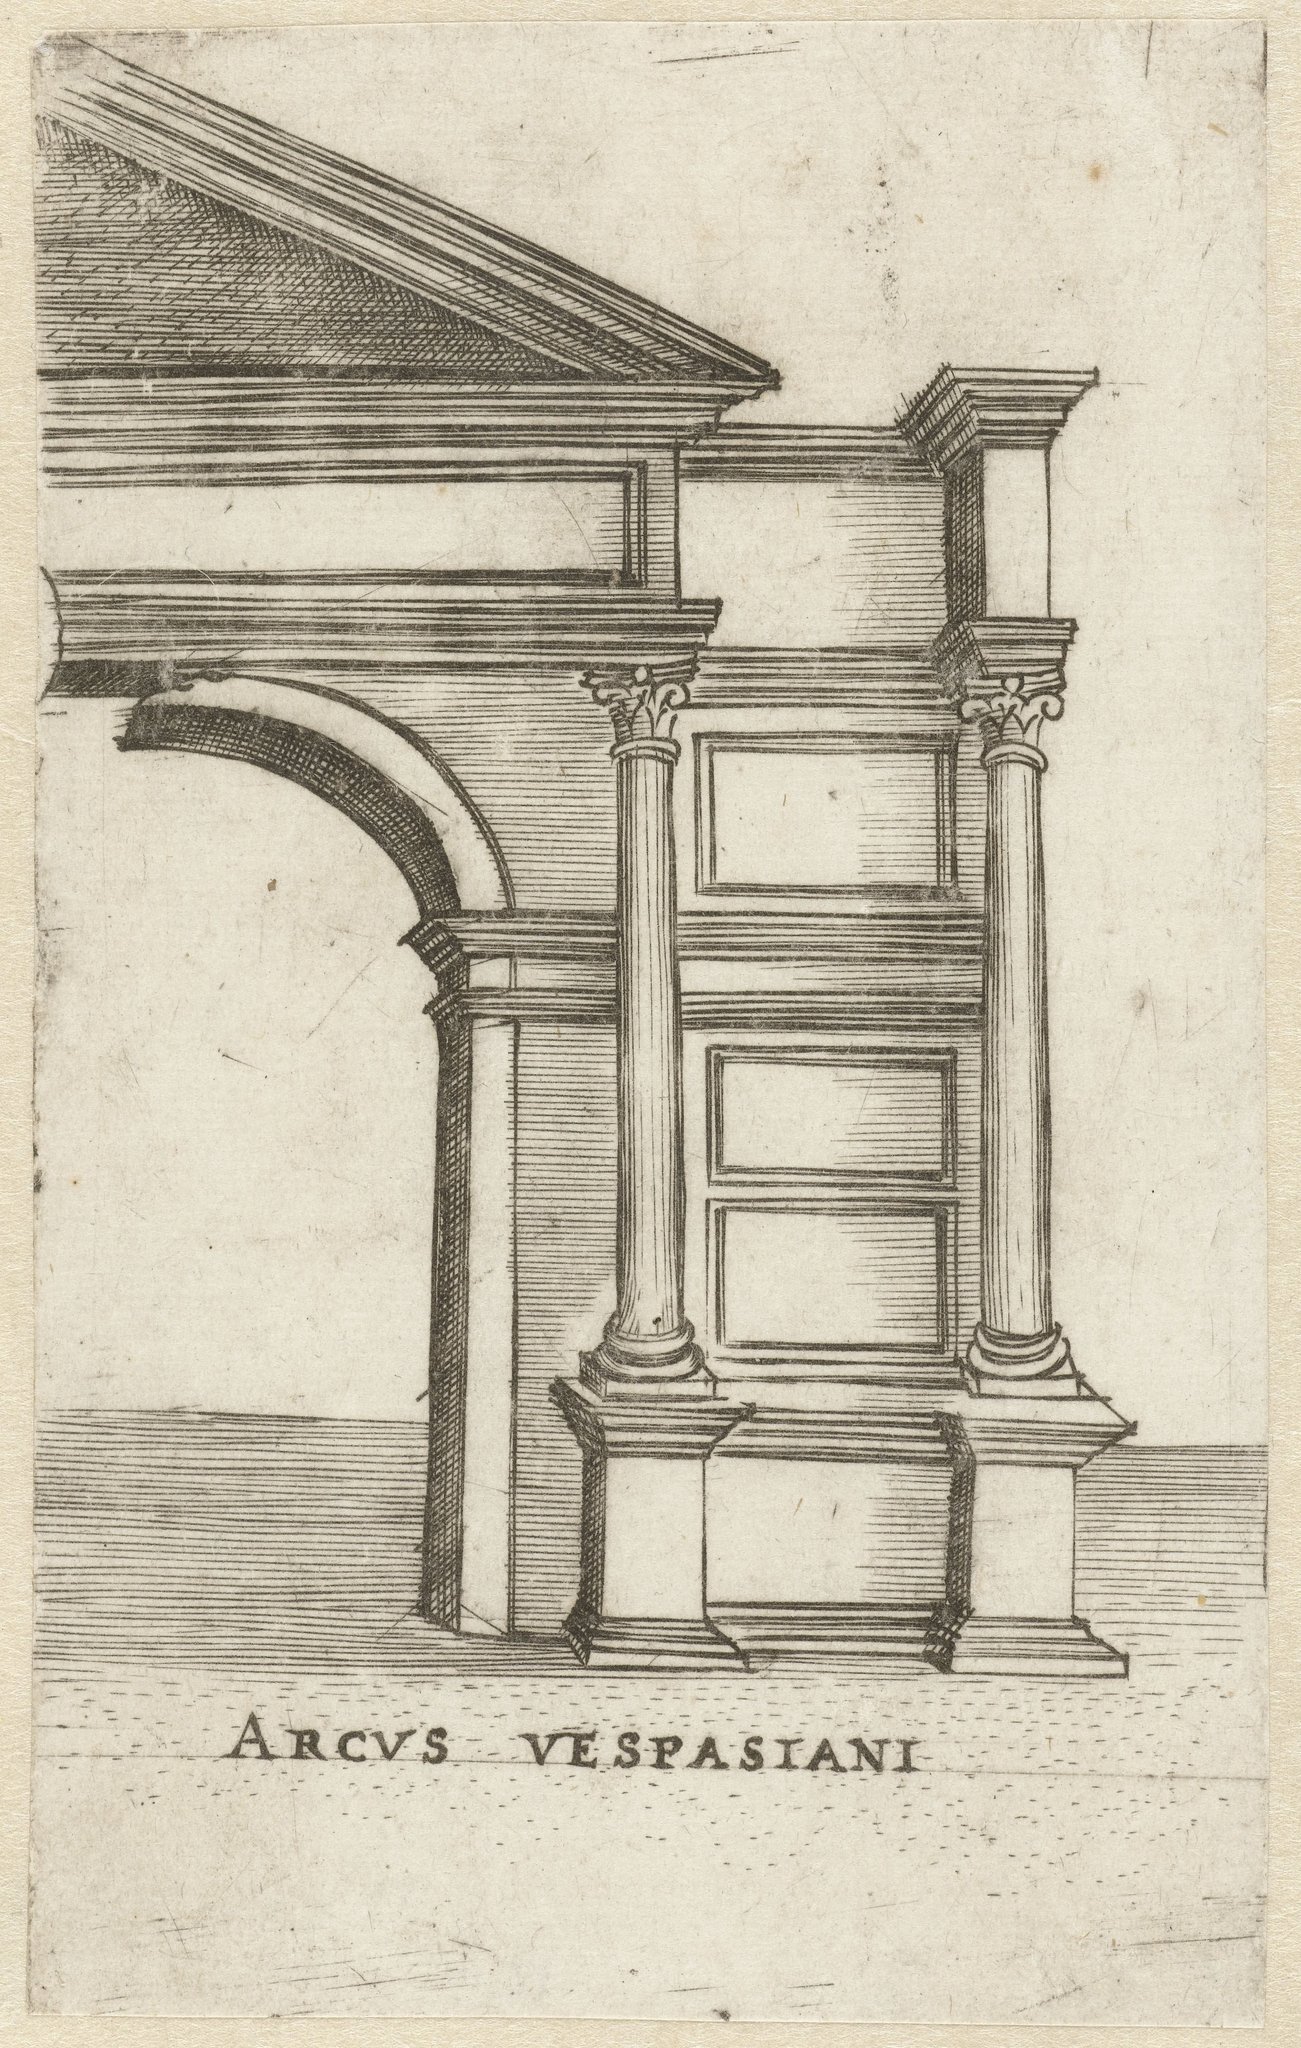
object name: print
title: Arcus vespasiani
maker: Anonymous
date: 1500-1549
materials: paper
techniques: engraving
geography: italy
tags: triumphal arch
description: Deel van een klassieke triomfboog die, blijkens het Latijnse onderschrift, ter ere van Vespasianus is opgericht (Titusboog te Rome): een doorgang en twee zuilen onder een architraaf waarop een timpaan rust. Deze prent is onderdeel van een serie prenten van antieke gebouwen.